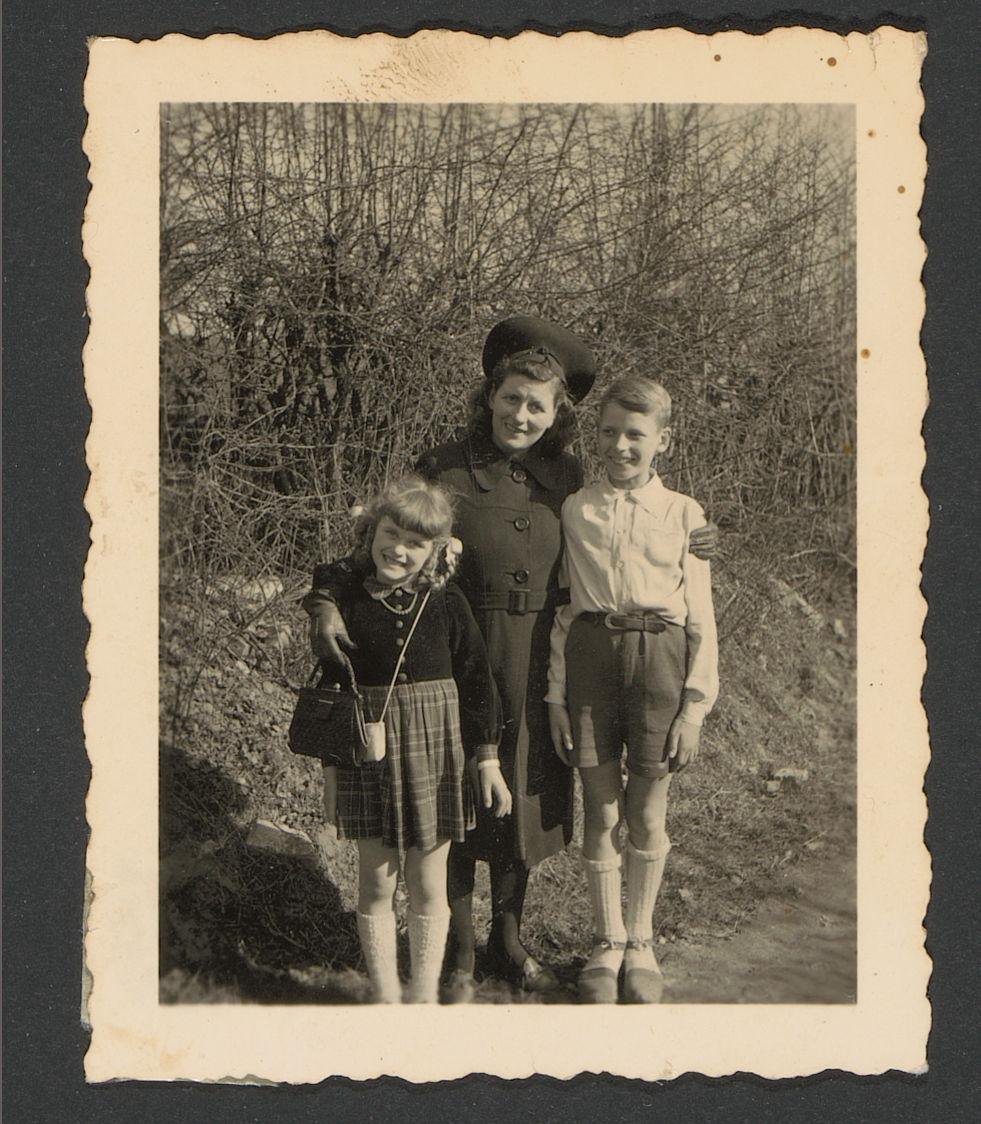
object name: album leaf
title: Portret van een vrouw met twee kinderen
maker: Anonymous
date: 1930-1945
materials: paper, photographic support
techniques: gelatin silver print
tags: adult woman, child, historical persons